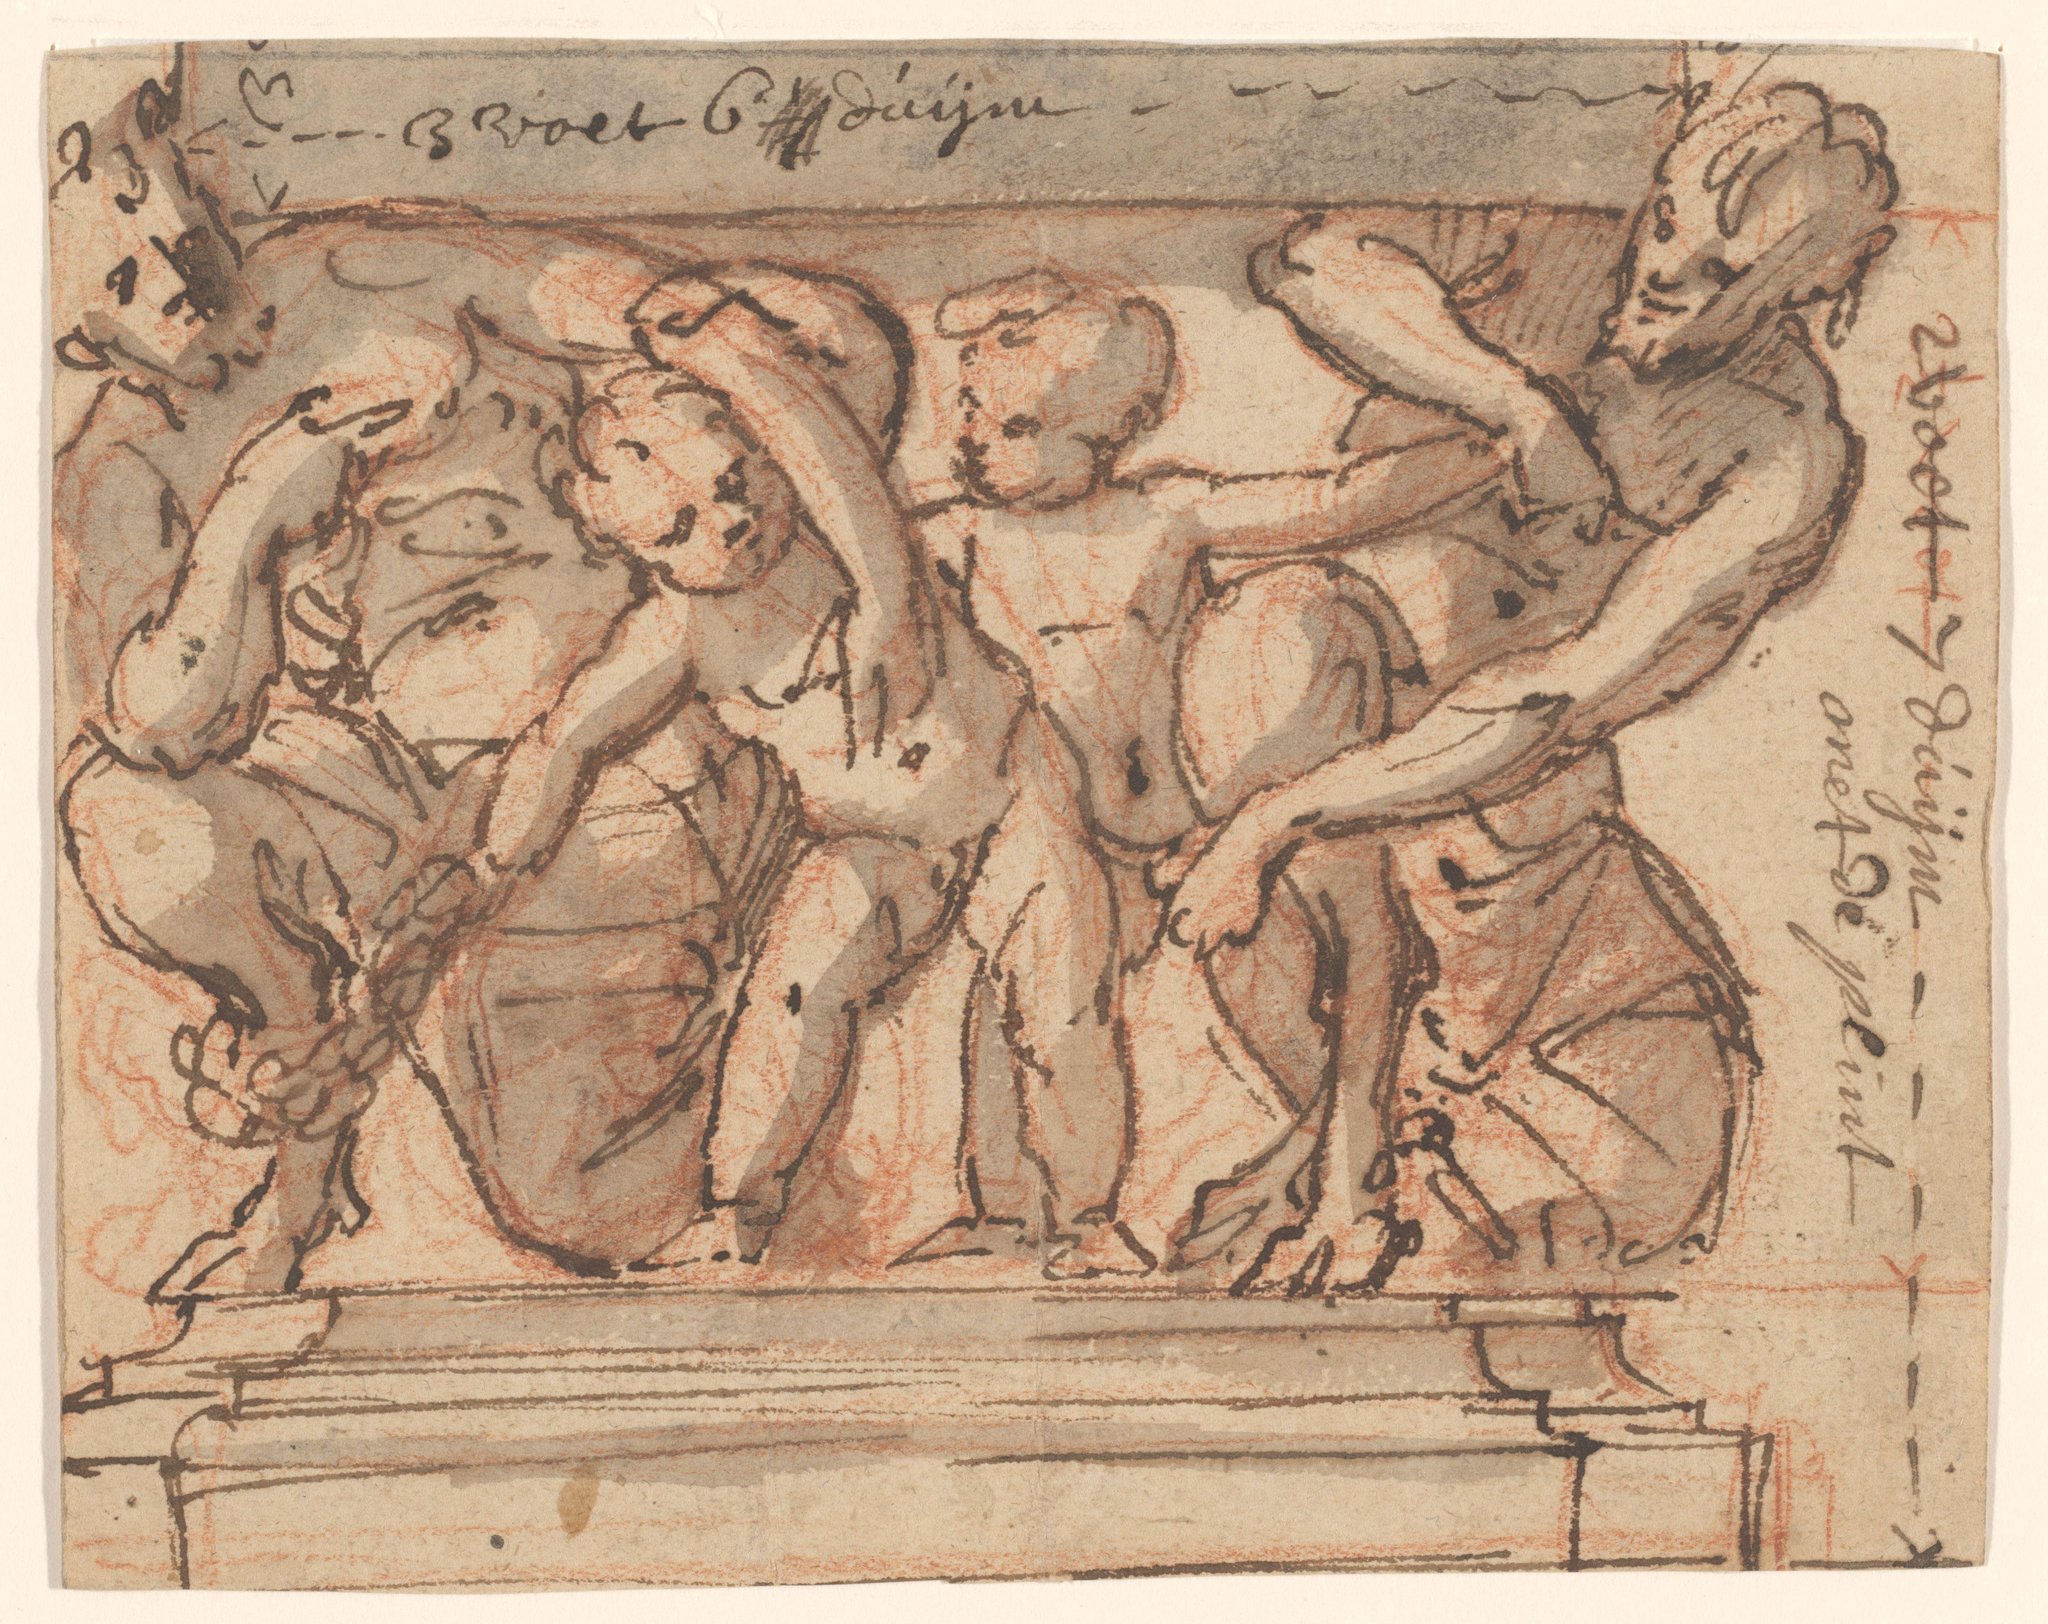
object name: drawing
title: Ontwerp voor een gebeeldhouwde voet, waarschijnlijk voor een kabinet of kist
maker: michiel van der voort (i)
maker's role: draughtsman, sculptor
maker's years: 1667-1737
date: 1700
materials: chalk, ink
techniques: brush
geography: antwerp